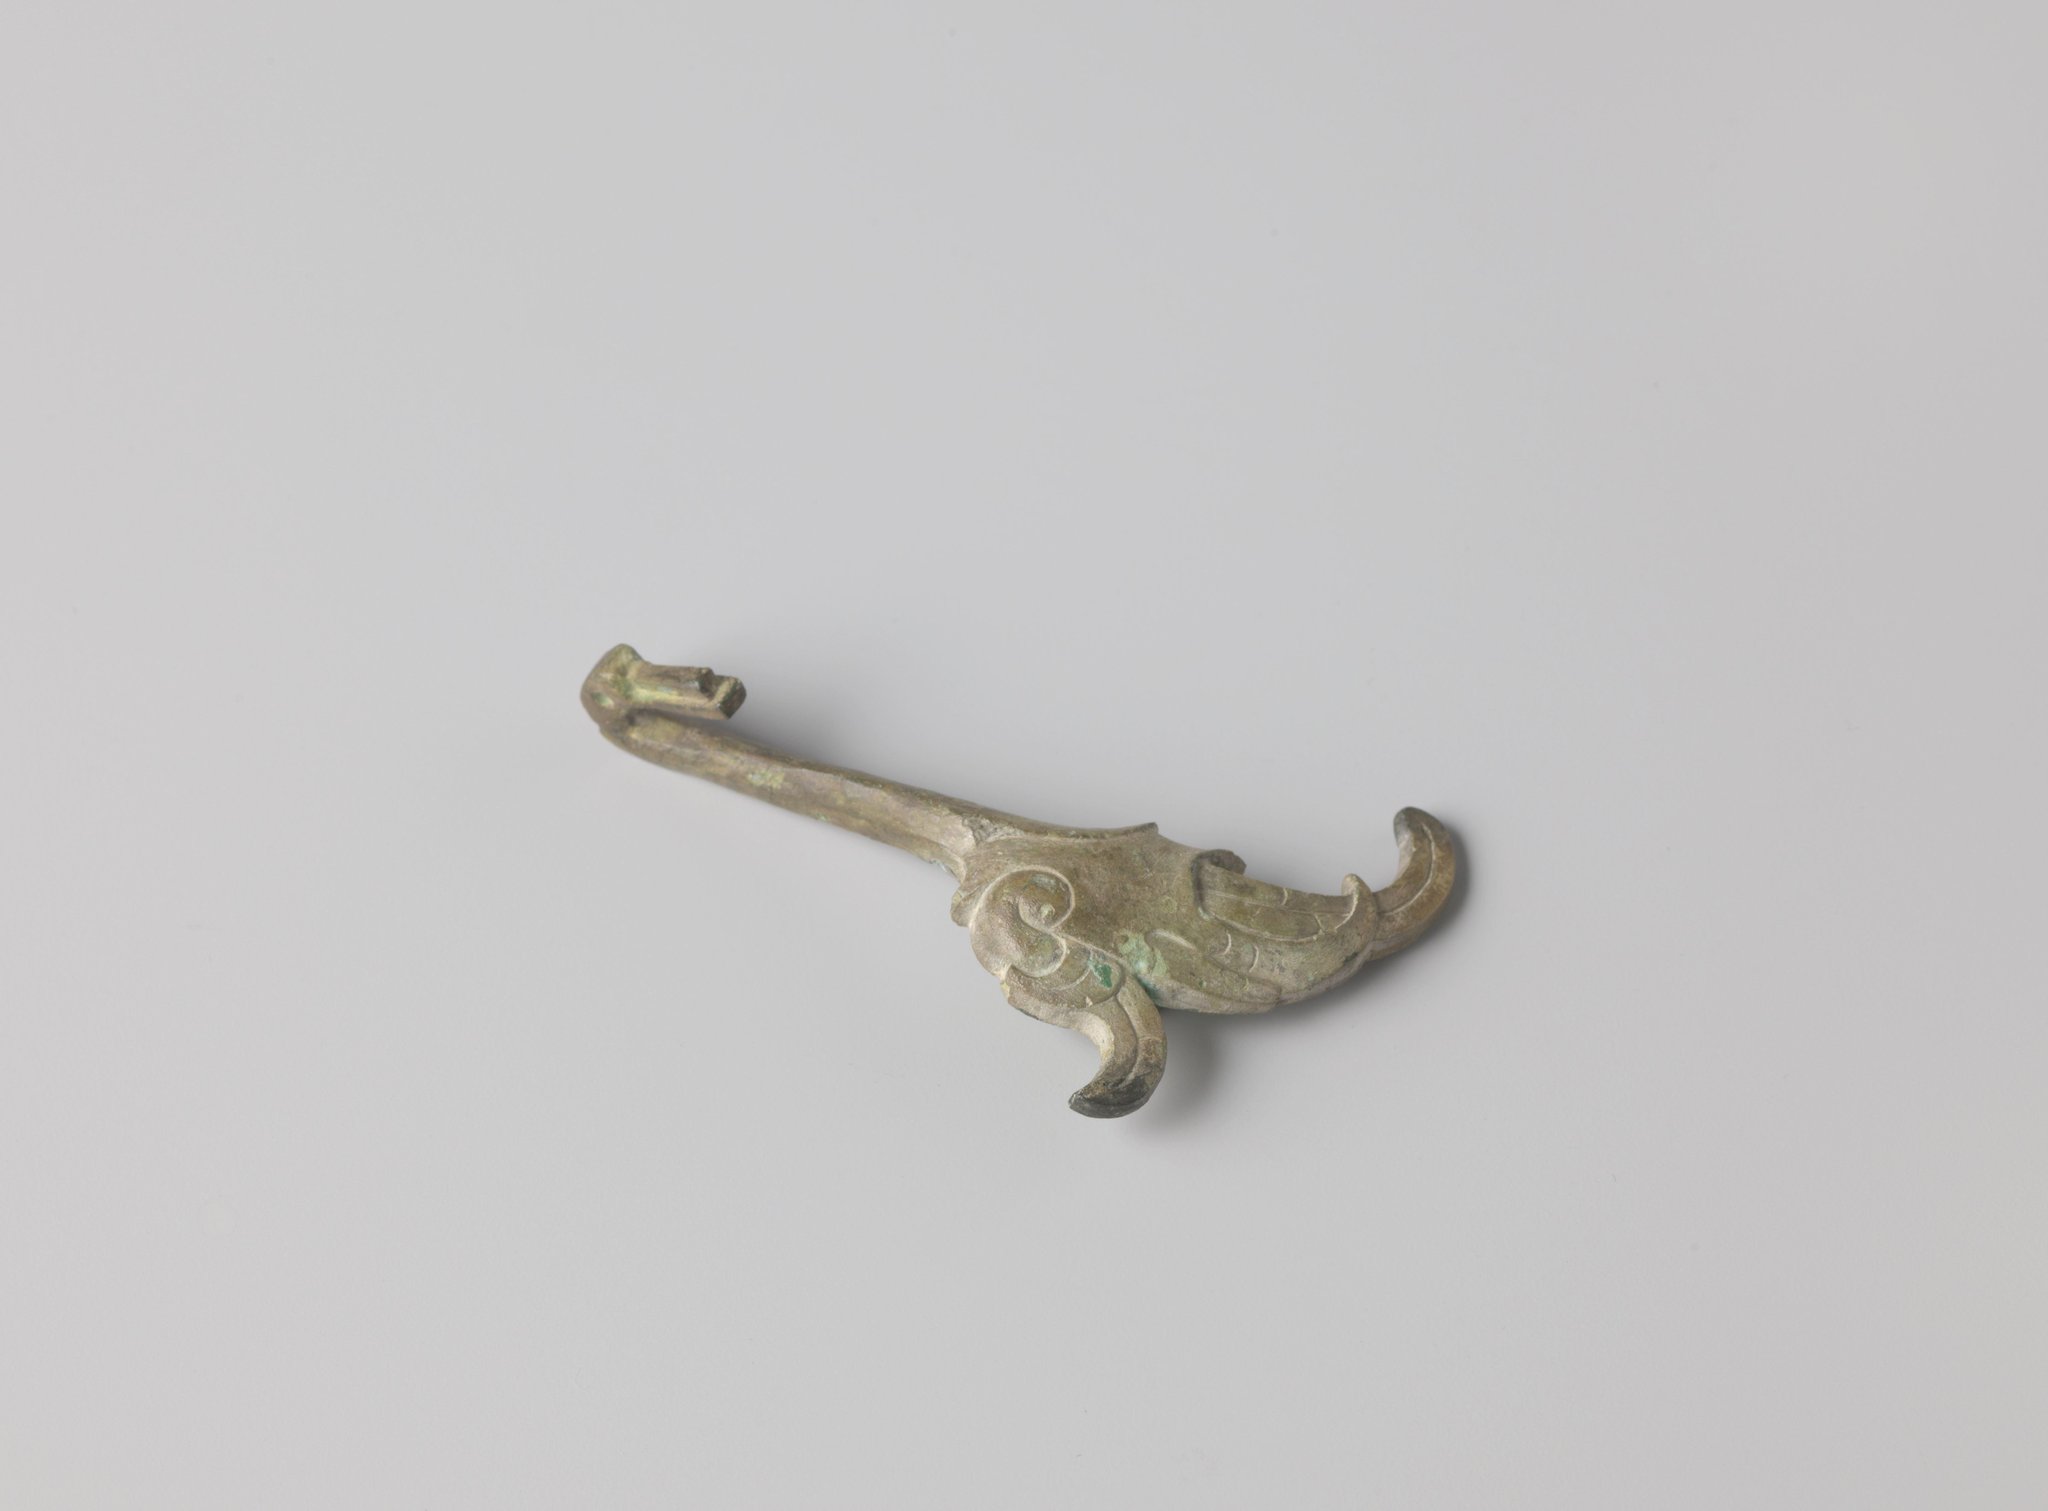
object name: gordelhaak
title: Gordelhaak in de vorm van een vogel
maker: Anonymous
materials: bronze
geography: china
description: Belt buckle in the form of a bird. On loan from R. Flaes.